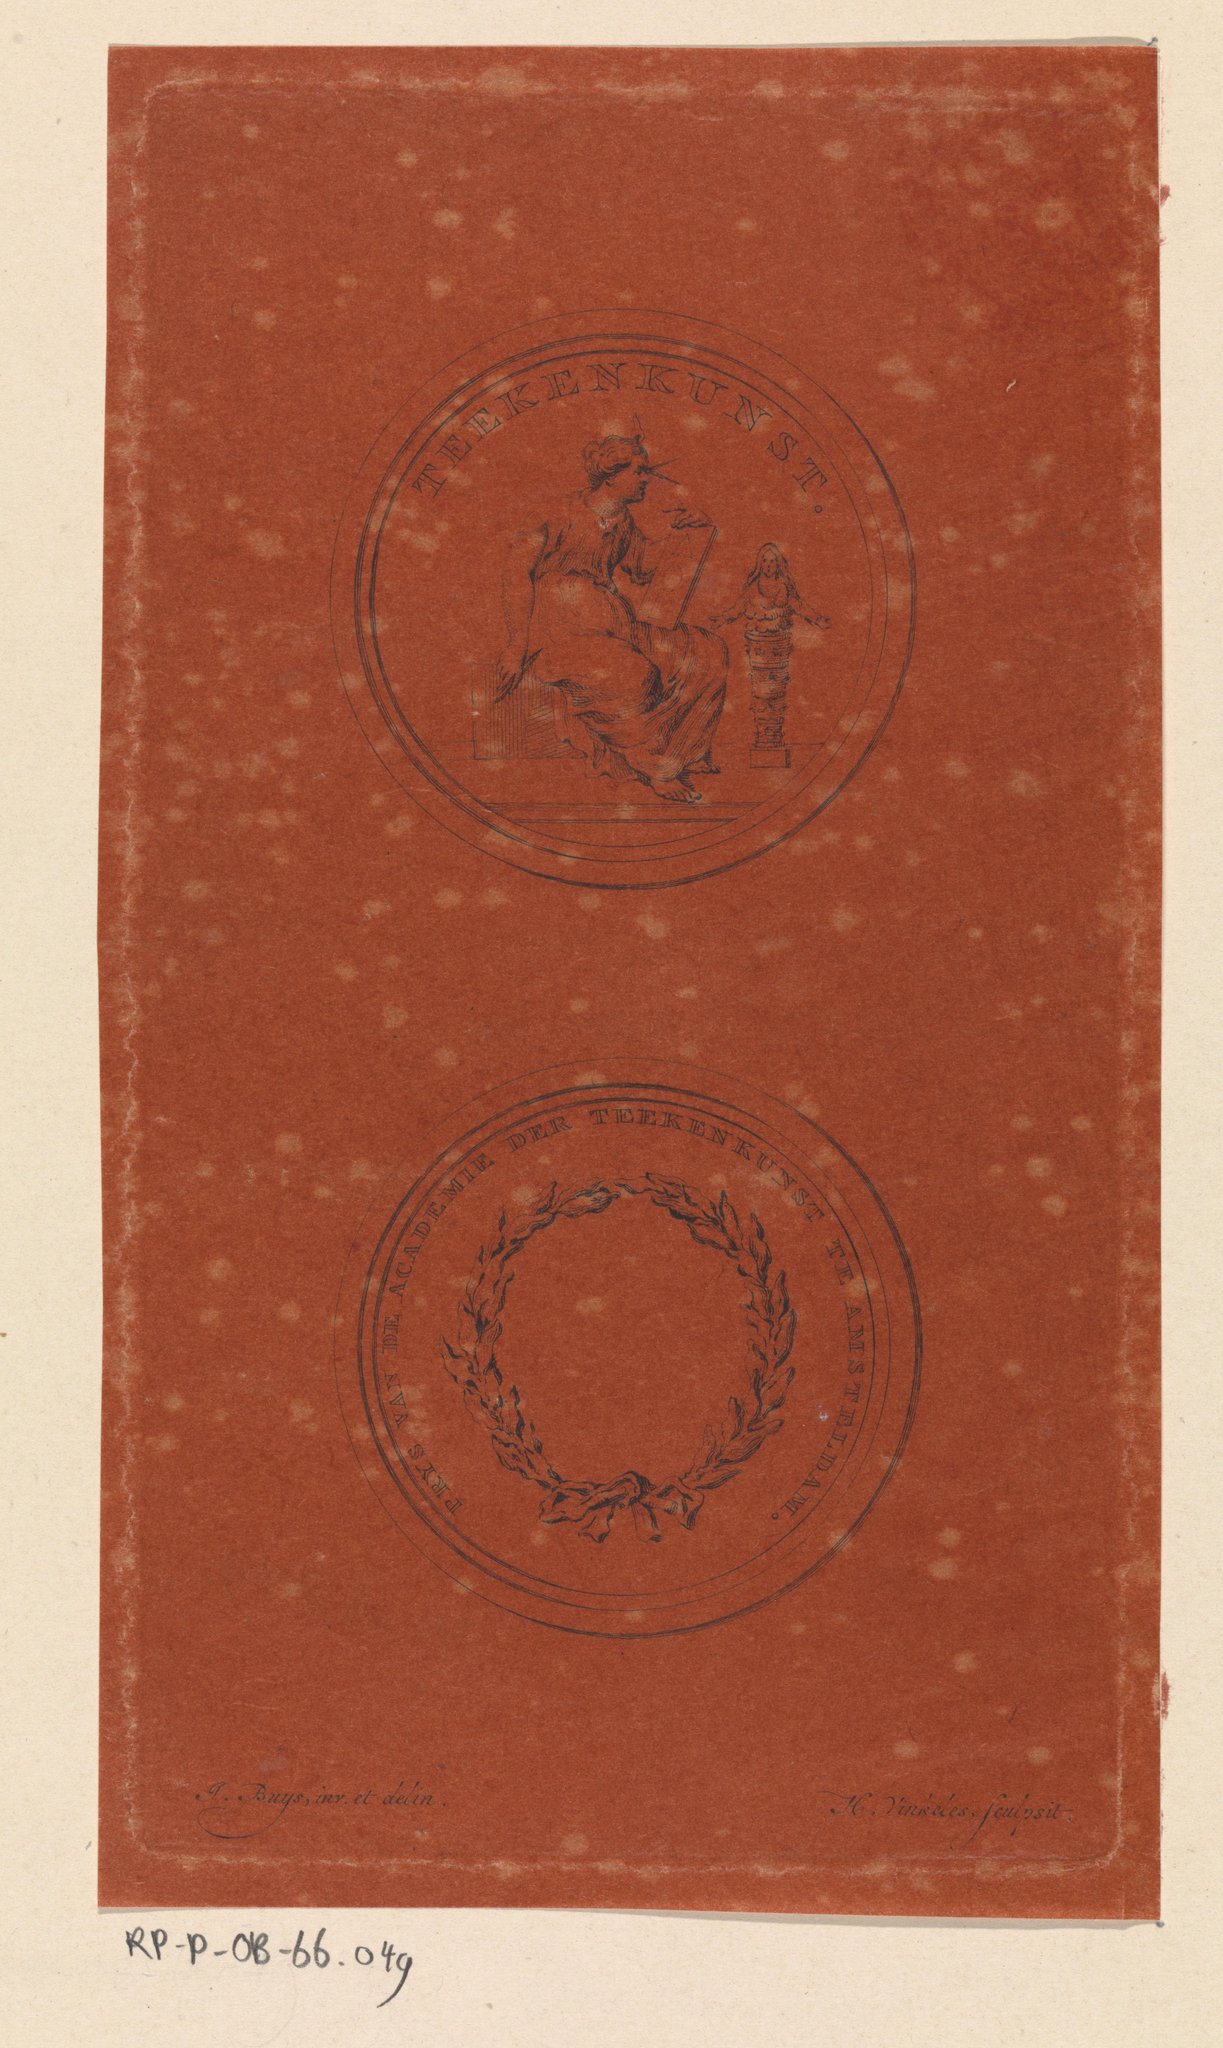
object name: print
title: Voor- en achterzijde van medaille van de academie der tekenkunst te Amsterdam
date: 1765-1800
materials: paper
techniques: engraving, etching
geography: amsterdam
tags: honouring the artist with laurel wreath (+ variant), memorial medal, compasses, symbolic representations, allegories and emblems ~ drawing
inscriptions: collector's mark: Lugt 240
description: Tekenkunst, afgebeeld als vrouw met vlam op hoofd, zit met pen en tekenbord in handen op steen tegenover een beeld, dat zij met passer in haar oog opmeet, binnen omschrift. Keerzijde: opschrift binnen lauwerkrans en omschrift.